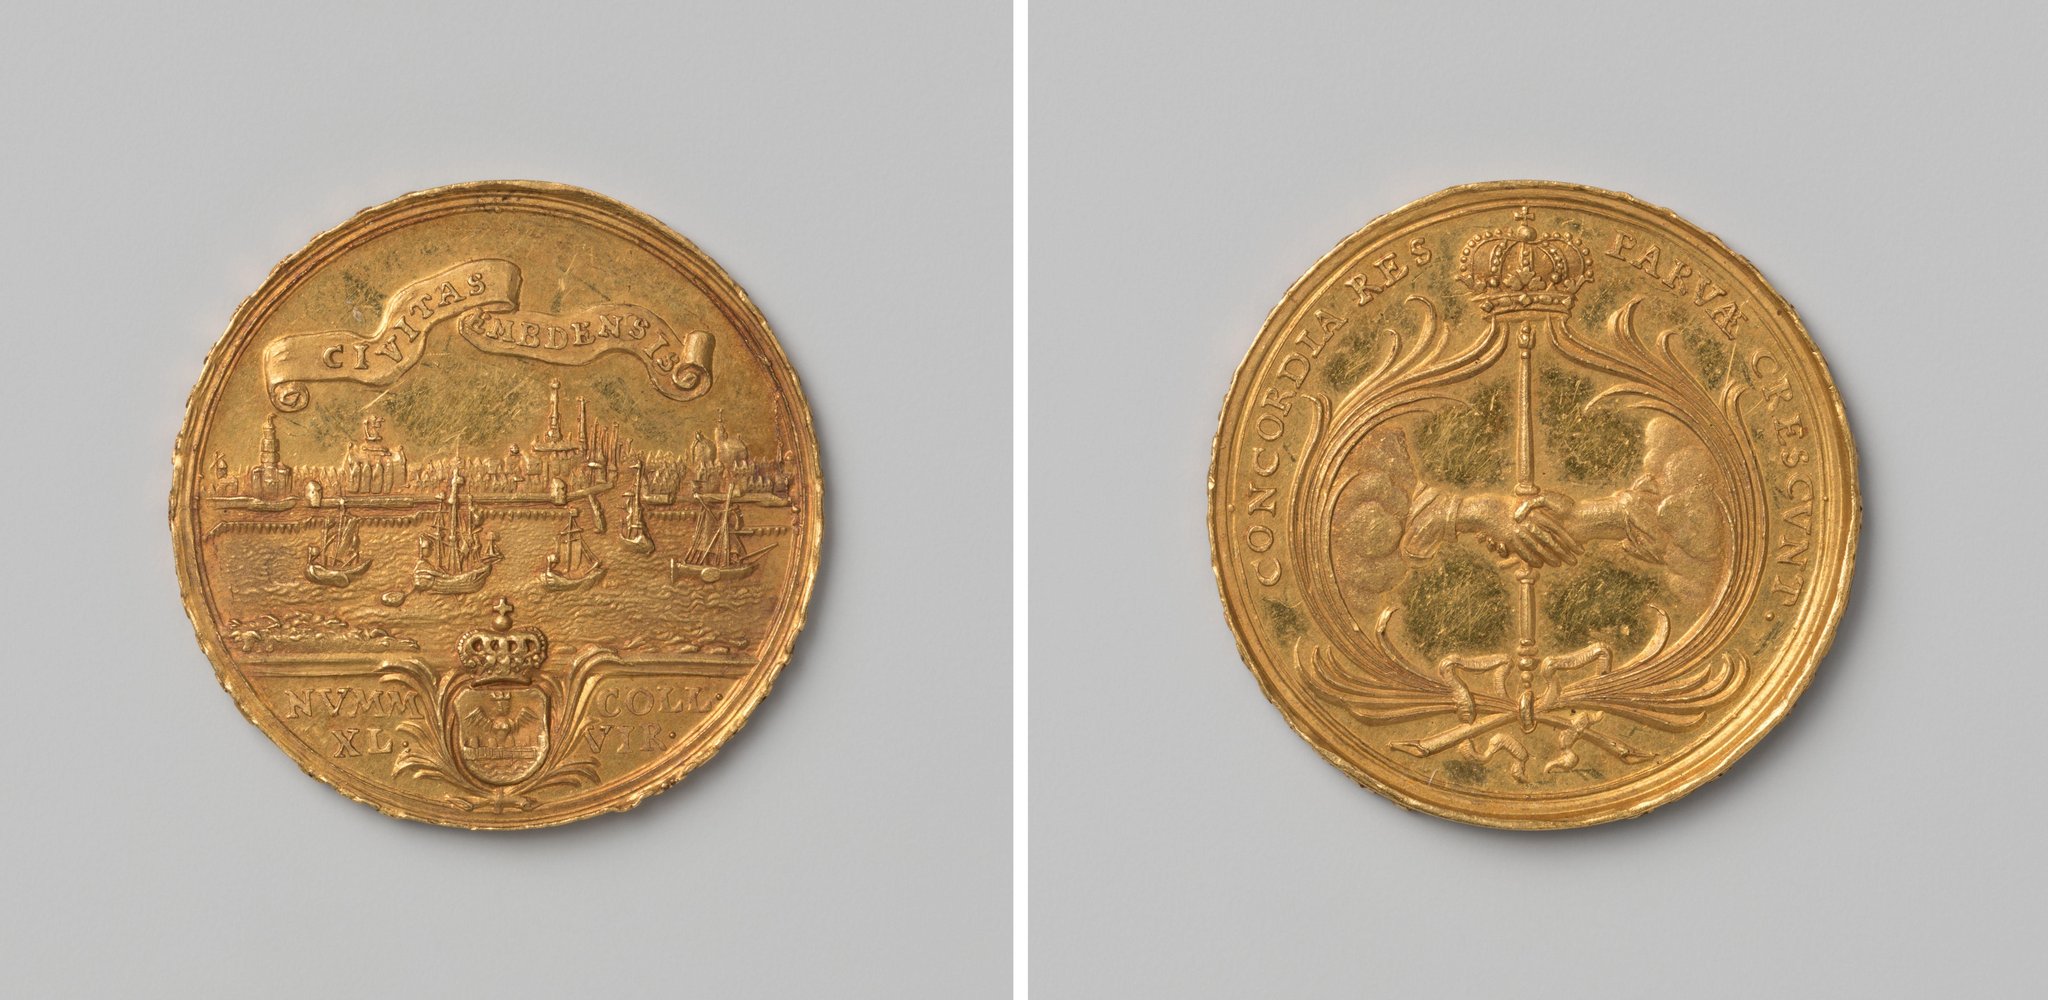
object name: council medal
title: Vroedschapspenning van de stad Embden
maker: Anonymous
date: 1743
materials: gold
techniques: striking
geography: emden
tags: emden